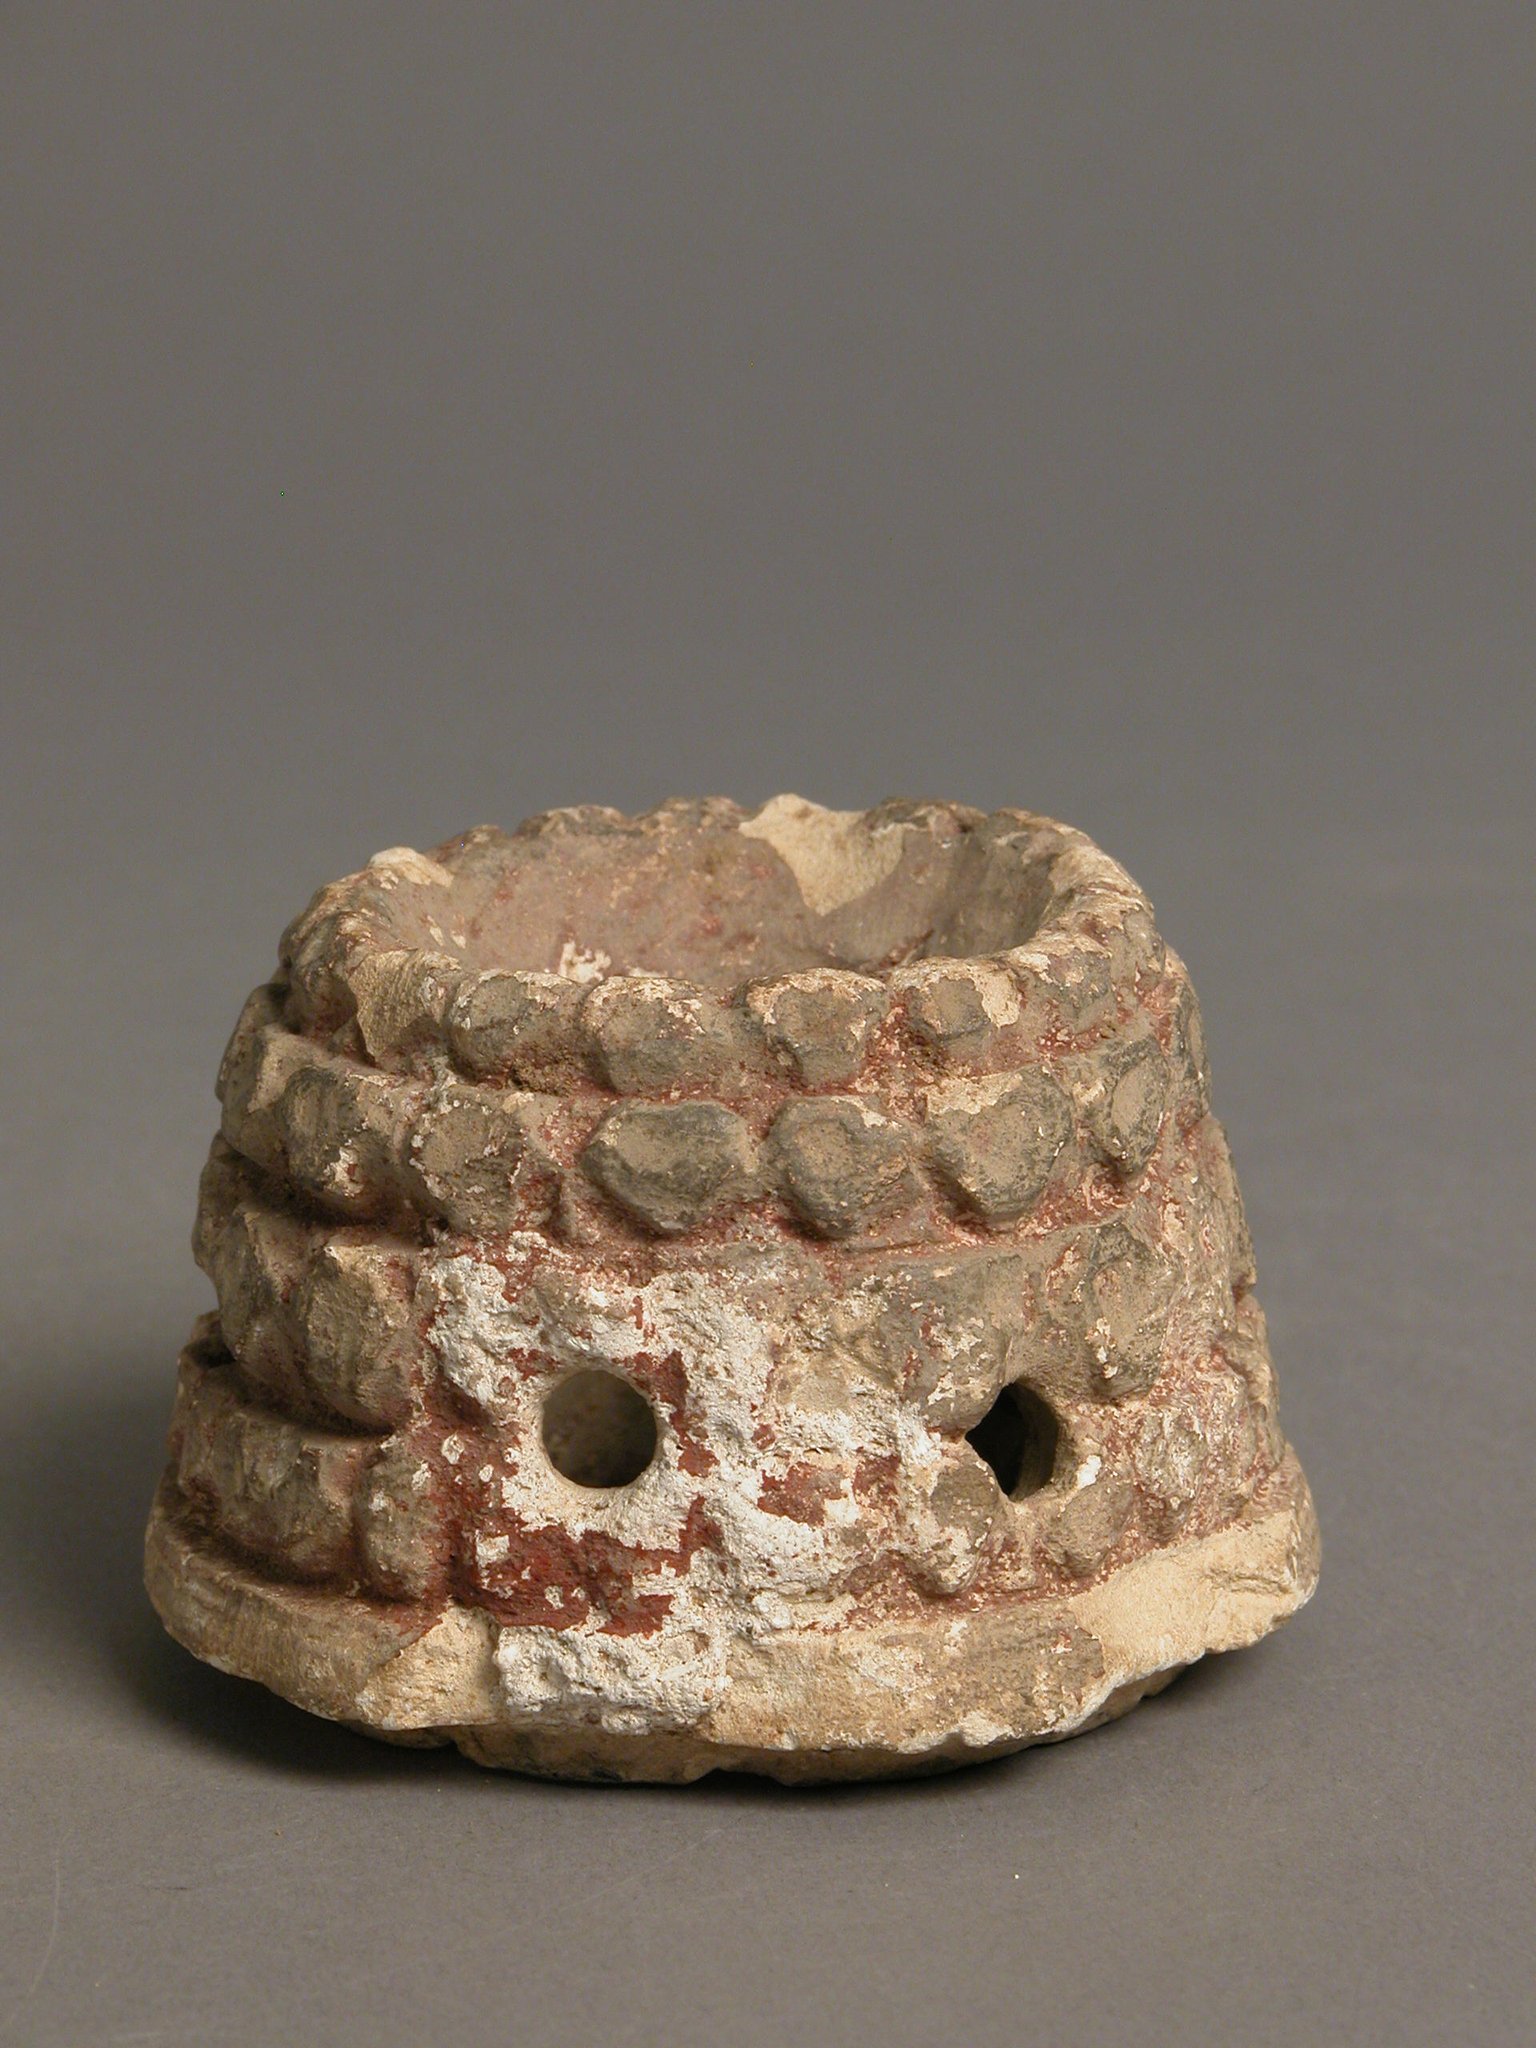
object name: incense burner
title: Top of Incense Burner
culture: coptic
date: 301-700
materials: earthenware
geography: egypt